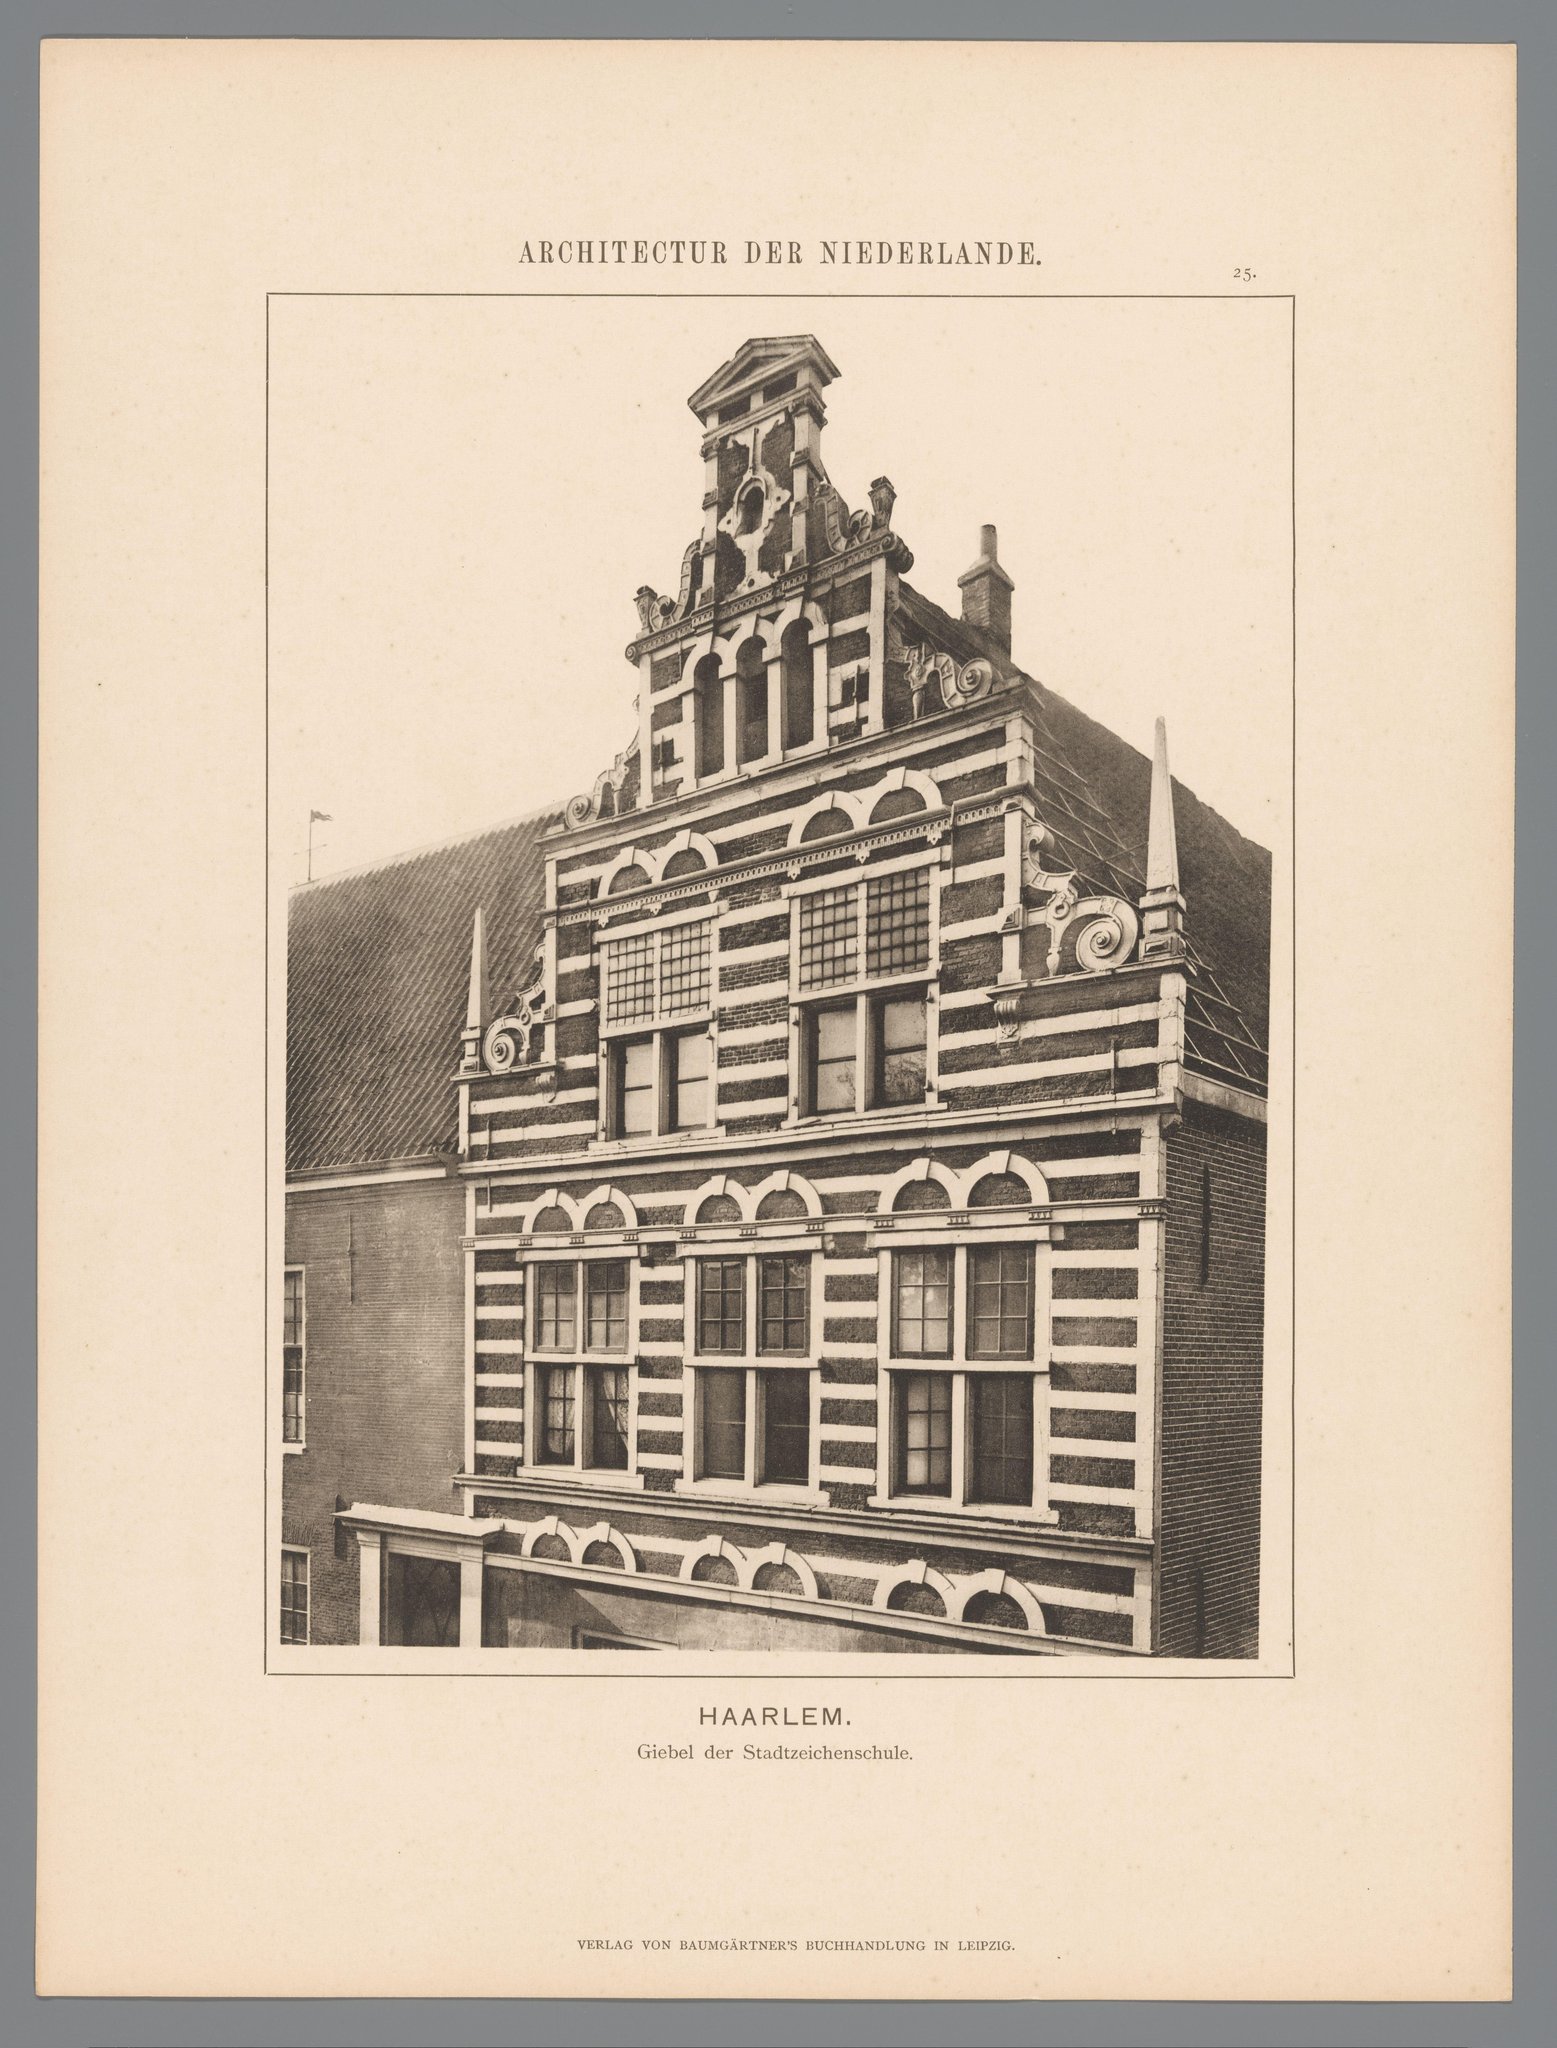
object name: book illustration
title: Haarlem. Giebel der Stadtzeichenschule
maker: Anonymous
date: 1894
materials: paper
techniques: photograph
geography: leipzig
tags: front façade, place or institution of education and training of the artist, e.g.: academy of art, haarlem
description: Afdruk uit: Krook, L. Architectur der Niederlande. Leipzig: Baumgärtner's Buchhandlung, 1894.